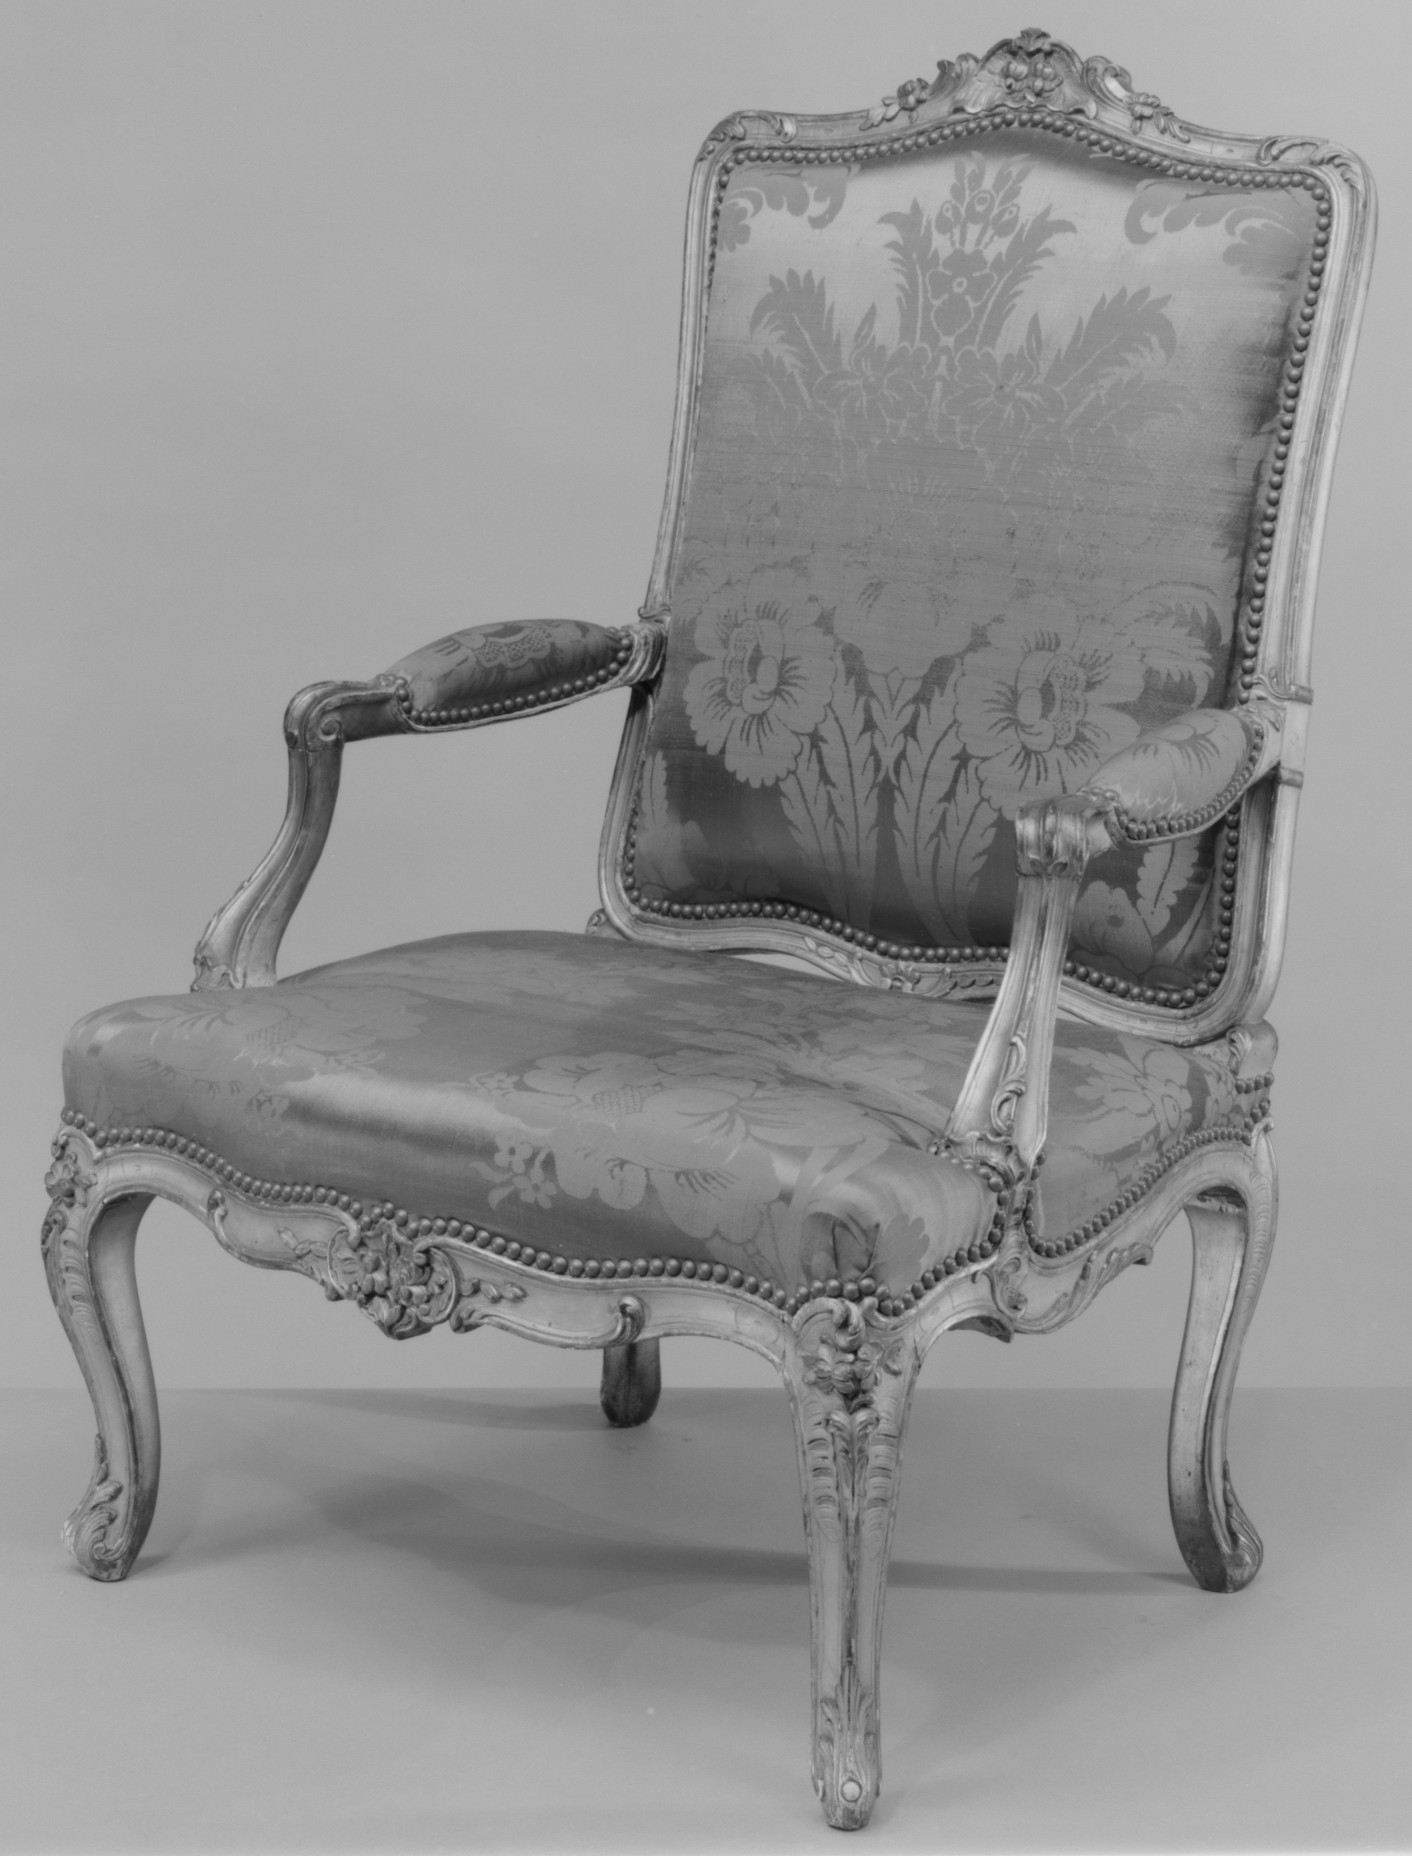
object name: armchair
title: Pair of armchairs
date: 1701-1750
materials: wood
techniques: carving, damask, gilding